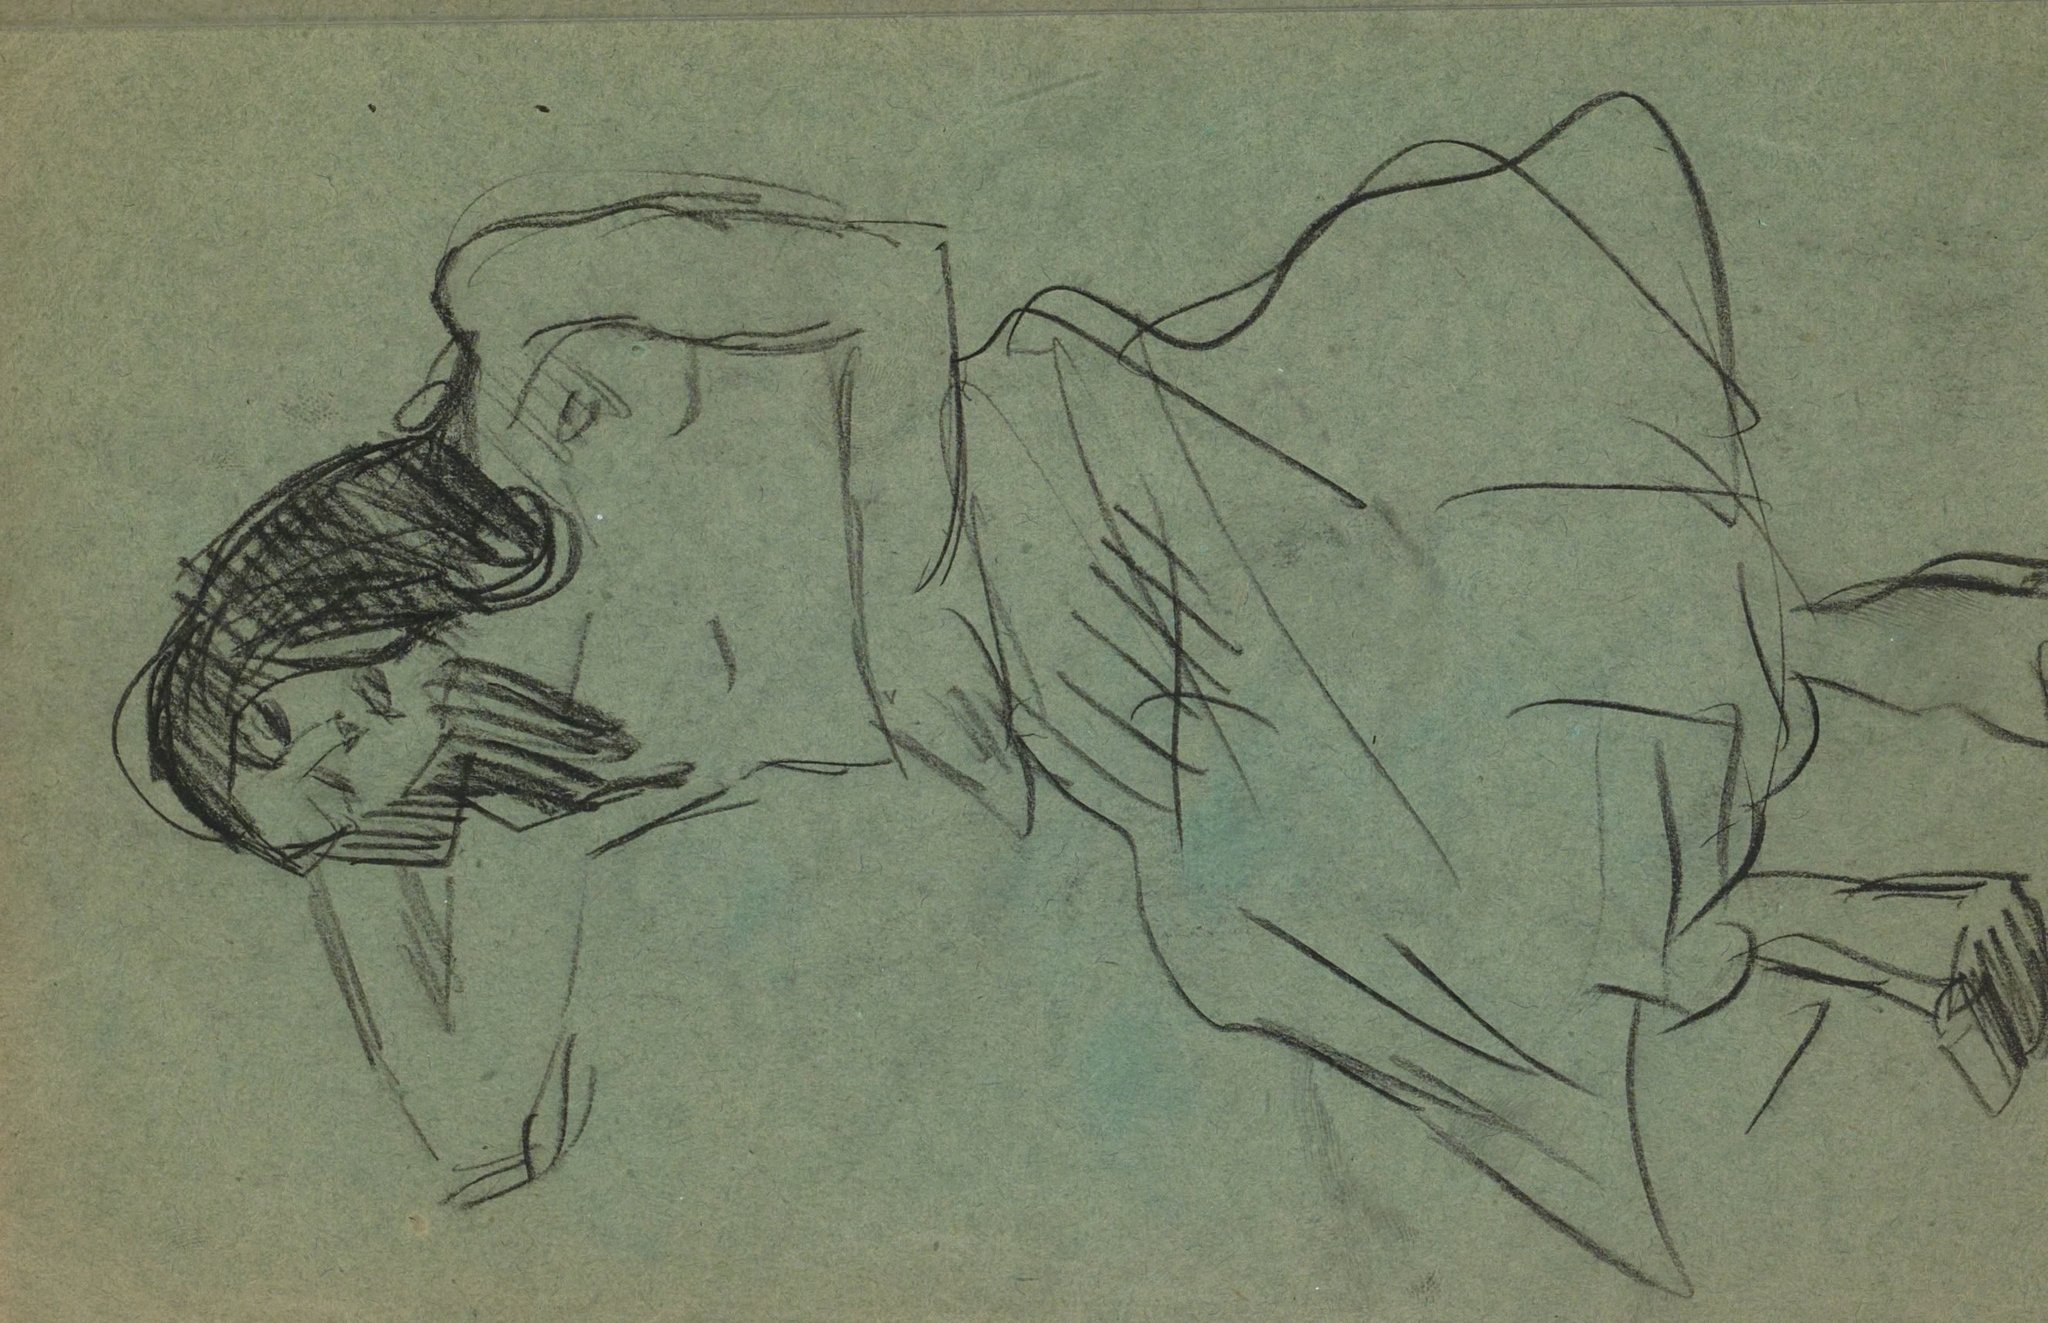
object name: sketchbook leaf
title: Zittende vrouw met een hand achter haar hoofd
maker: isaac israels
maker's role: draughtsman, painter, print maker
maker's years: 1865-1934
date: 1875-1934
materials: chalk, paper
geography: paris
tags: hand behind the head, adult woman (+ sitting), eyes closed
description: Ze slaapt mogelijk. Binnenzijde van de voorkant van het omslag van schetsboek LI met 11 bladen.